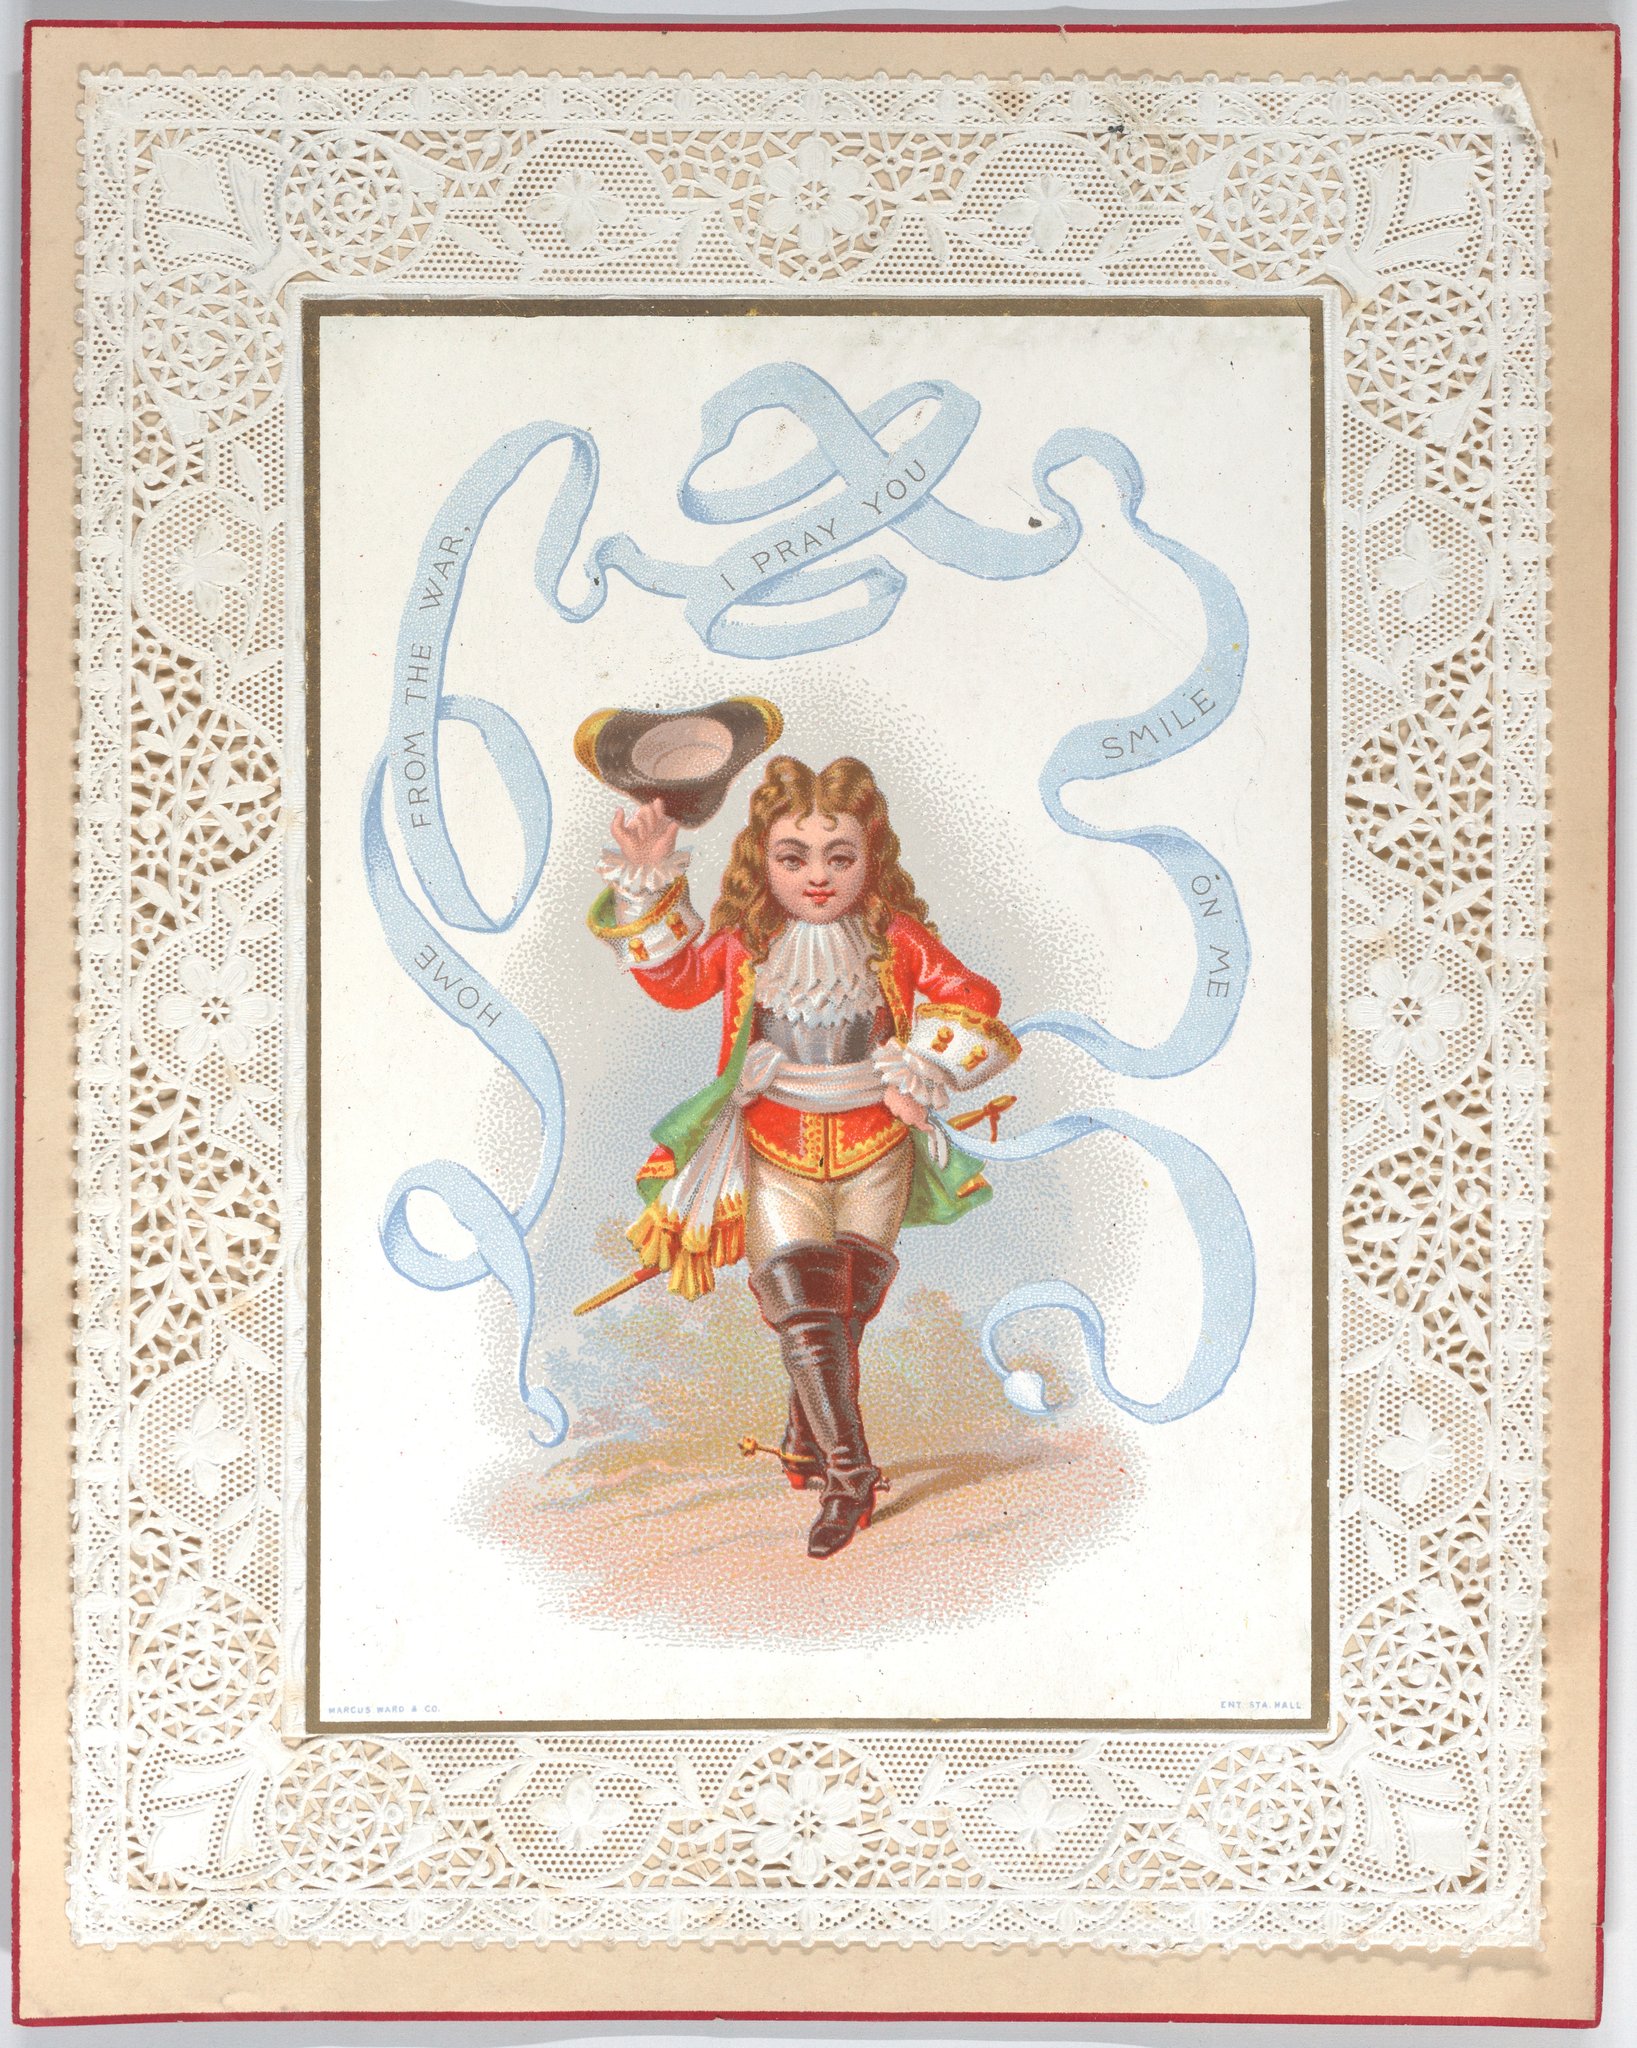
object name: valentine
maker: Anonymous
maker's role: artist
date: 1880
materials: gold, lace, paper, watercolor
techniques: chromolithography, lithograph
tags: soldiers,men